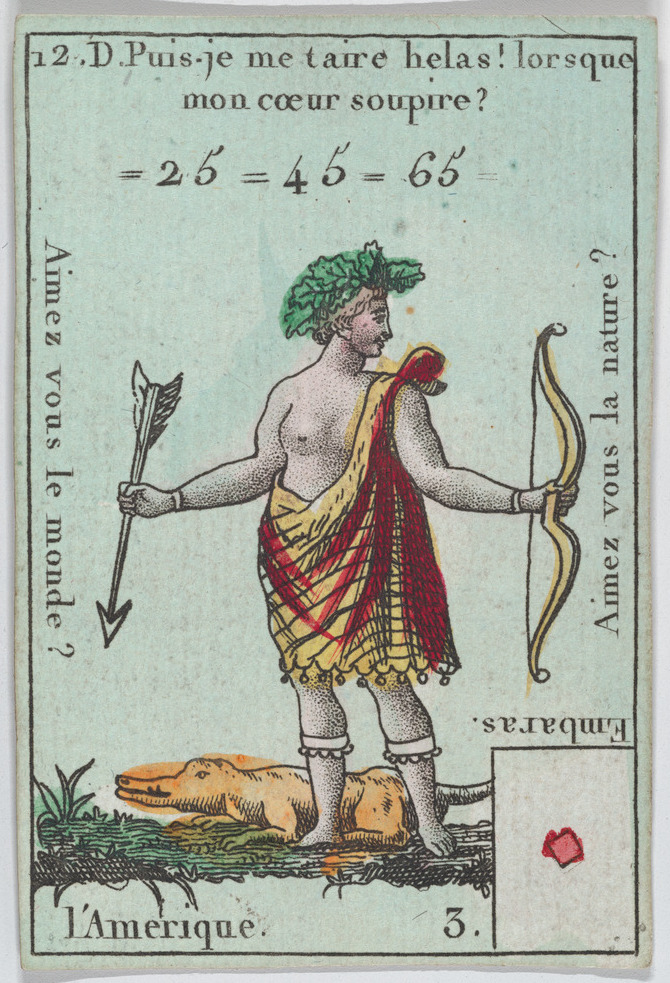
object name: print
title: L'Amerique from playing cards "Jeu d'Or"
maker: anonymous, french, 18th century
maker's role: artist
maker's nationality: french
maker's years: 1700-1800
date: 1700-1799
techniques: etching, hand coloring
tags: bow and arrow,men,profiles,playing cards,crocodiles